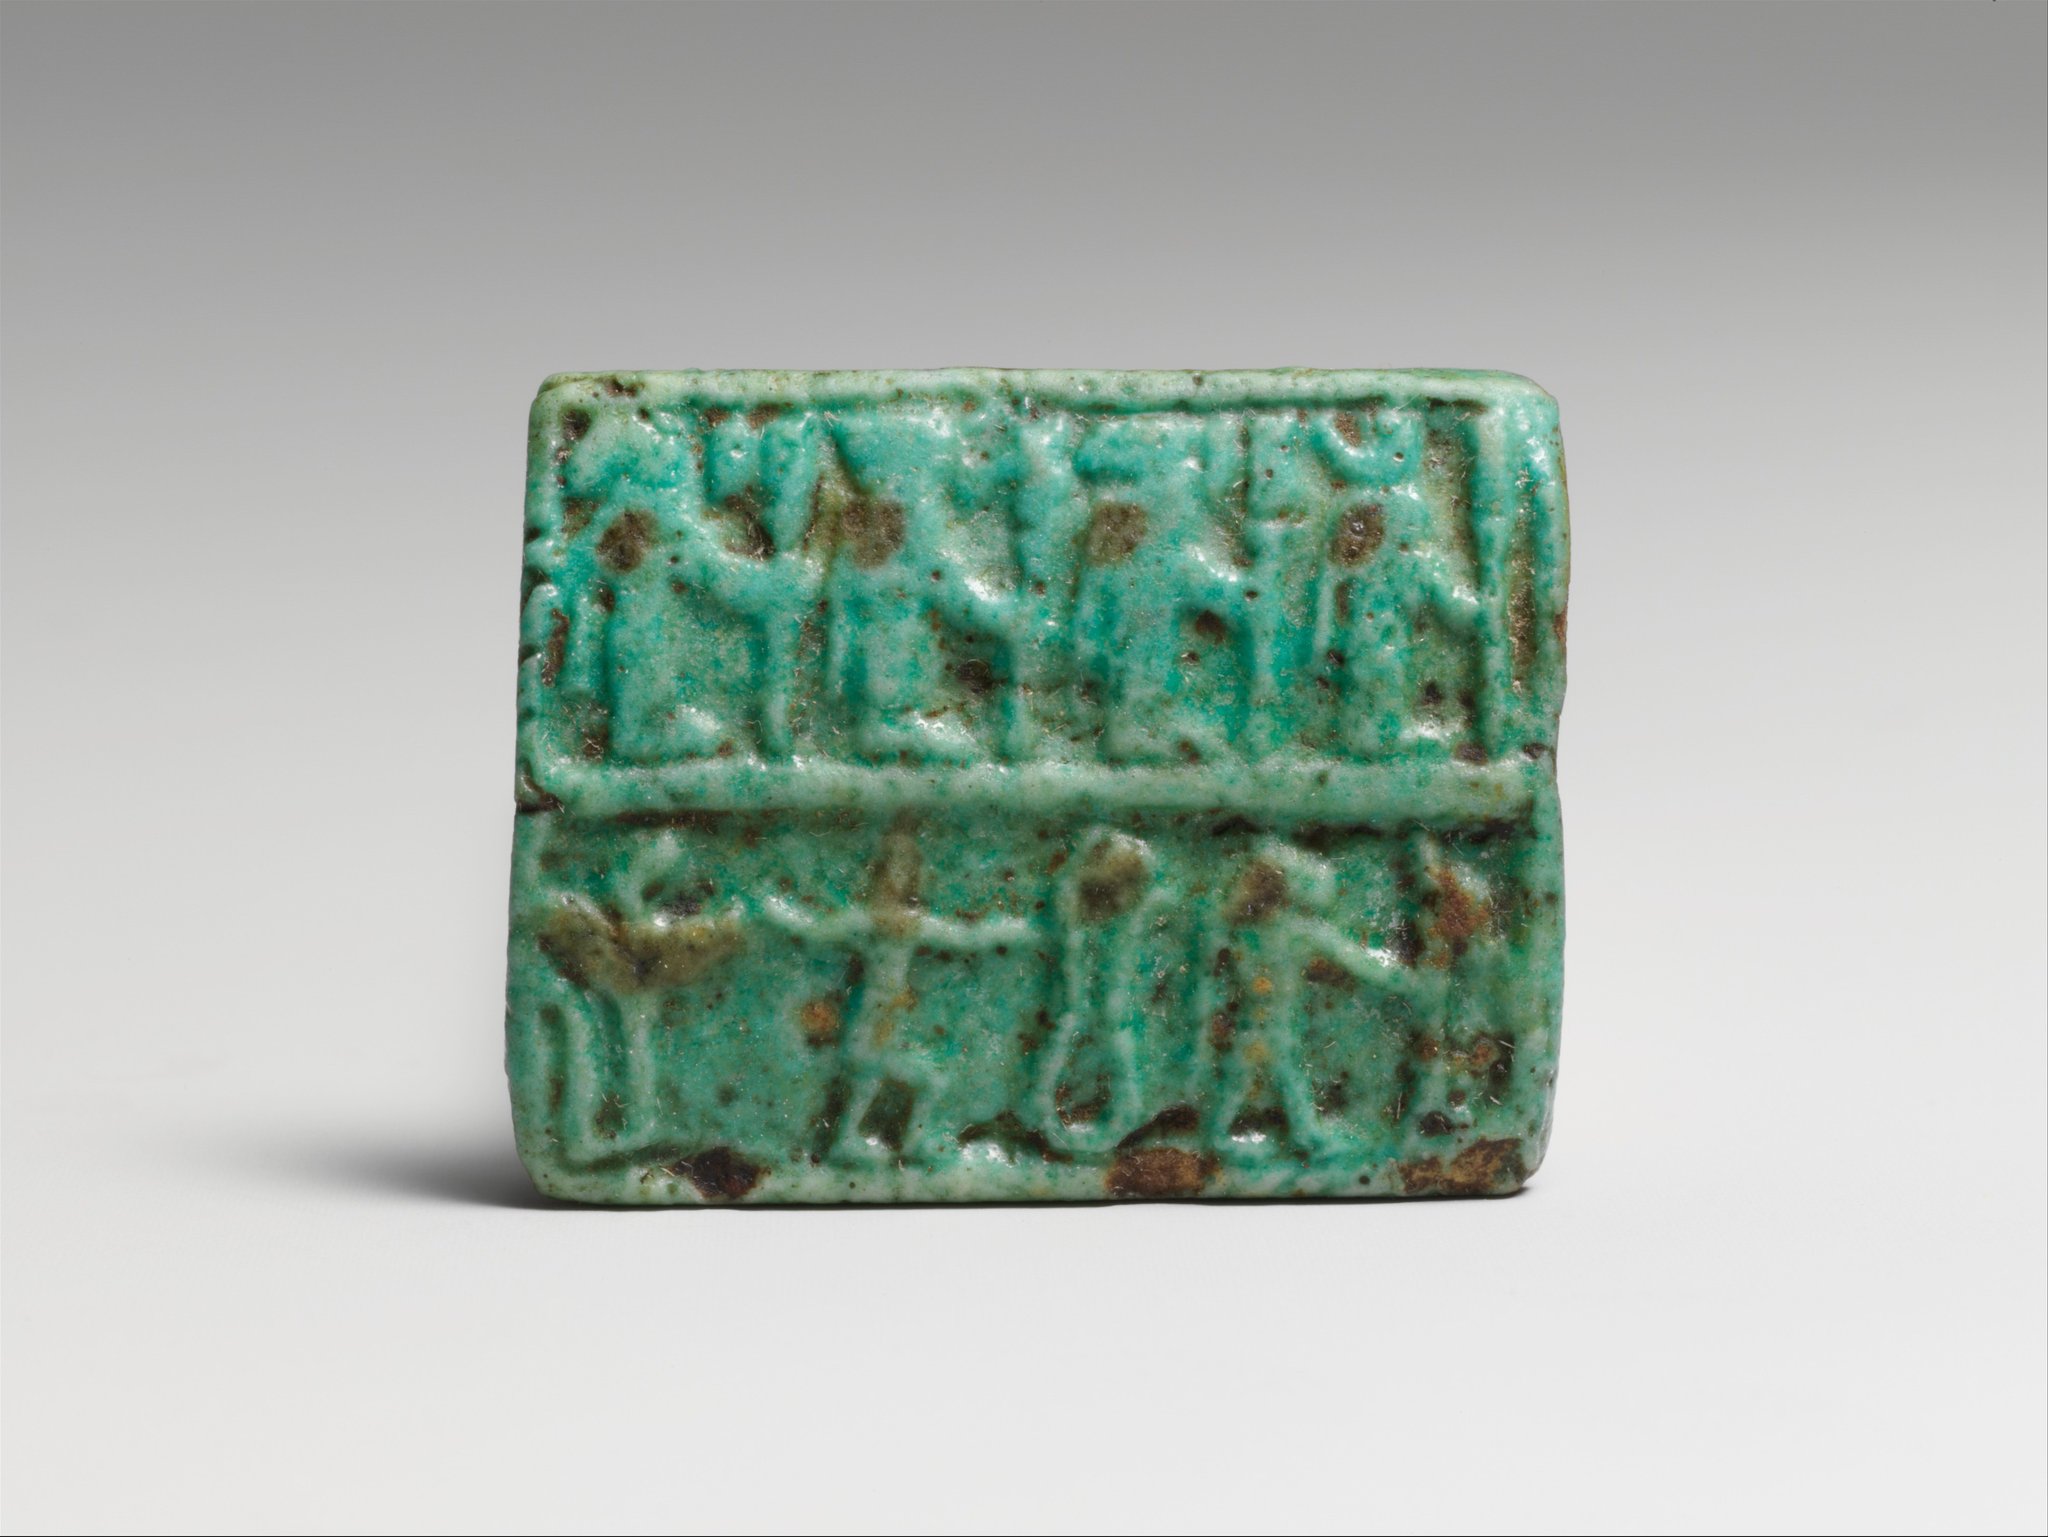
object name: amulet plaque, group of deity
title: Faience amulet plaque with several deities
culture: egyptian or levantine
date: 1050-900 BCE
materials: faience